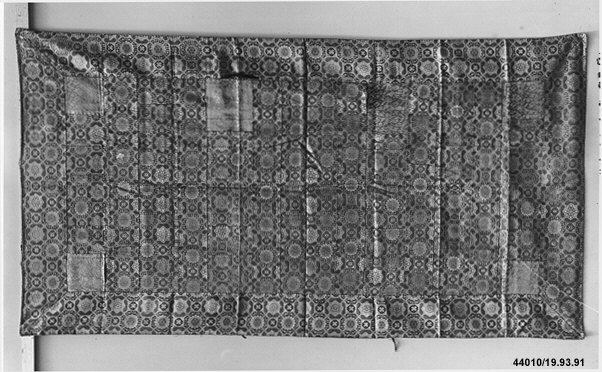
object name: robe, priest's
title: Priest's Robe (Shichijō)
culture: japanese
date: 1748-1751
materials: metal thread, silk